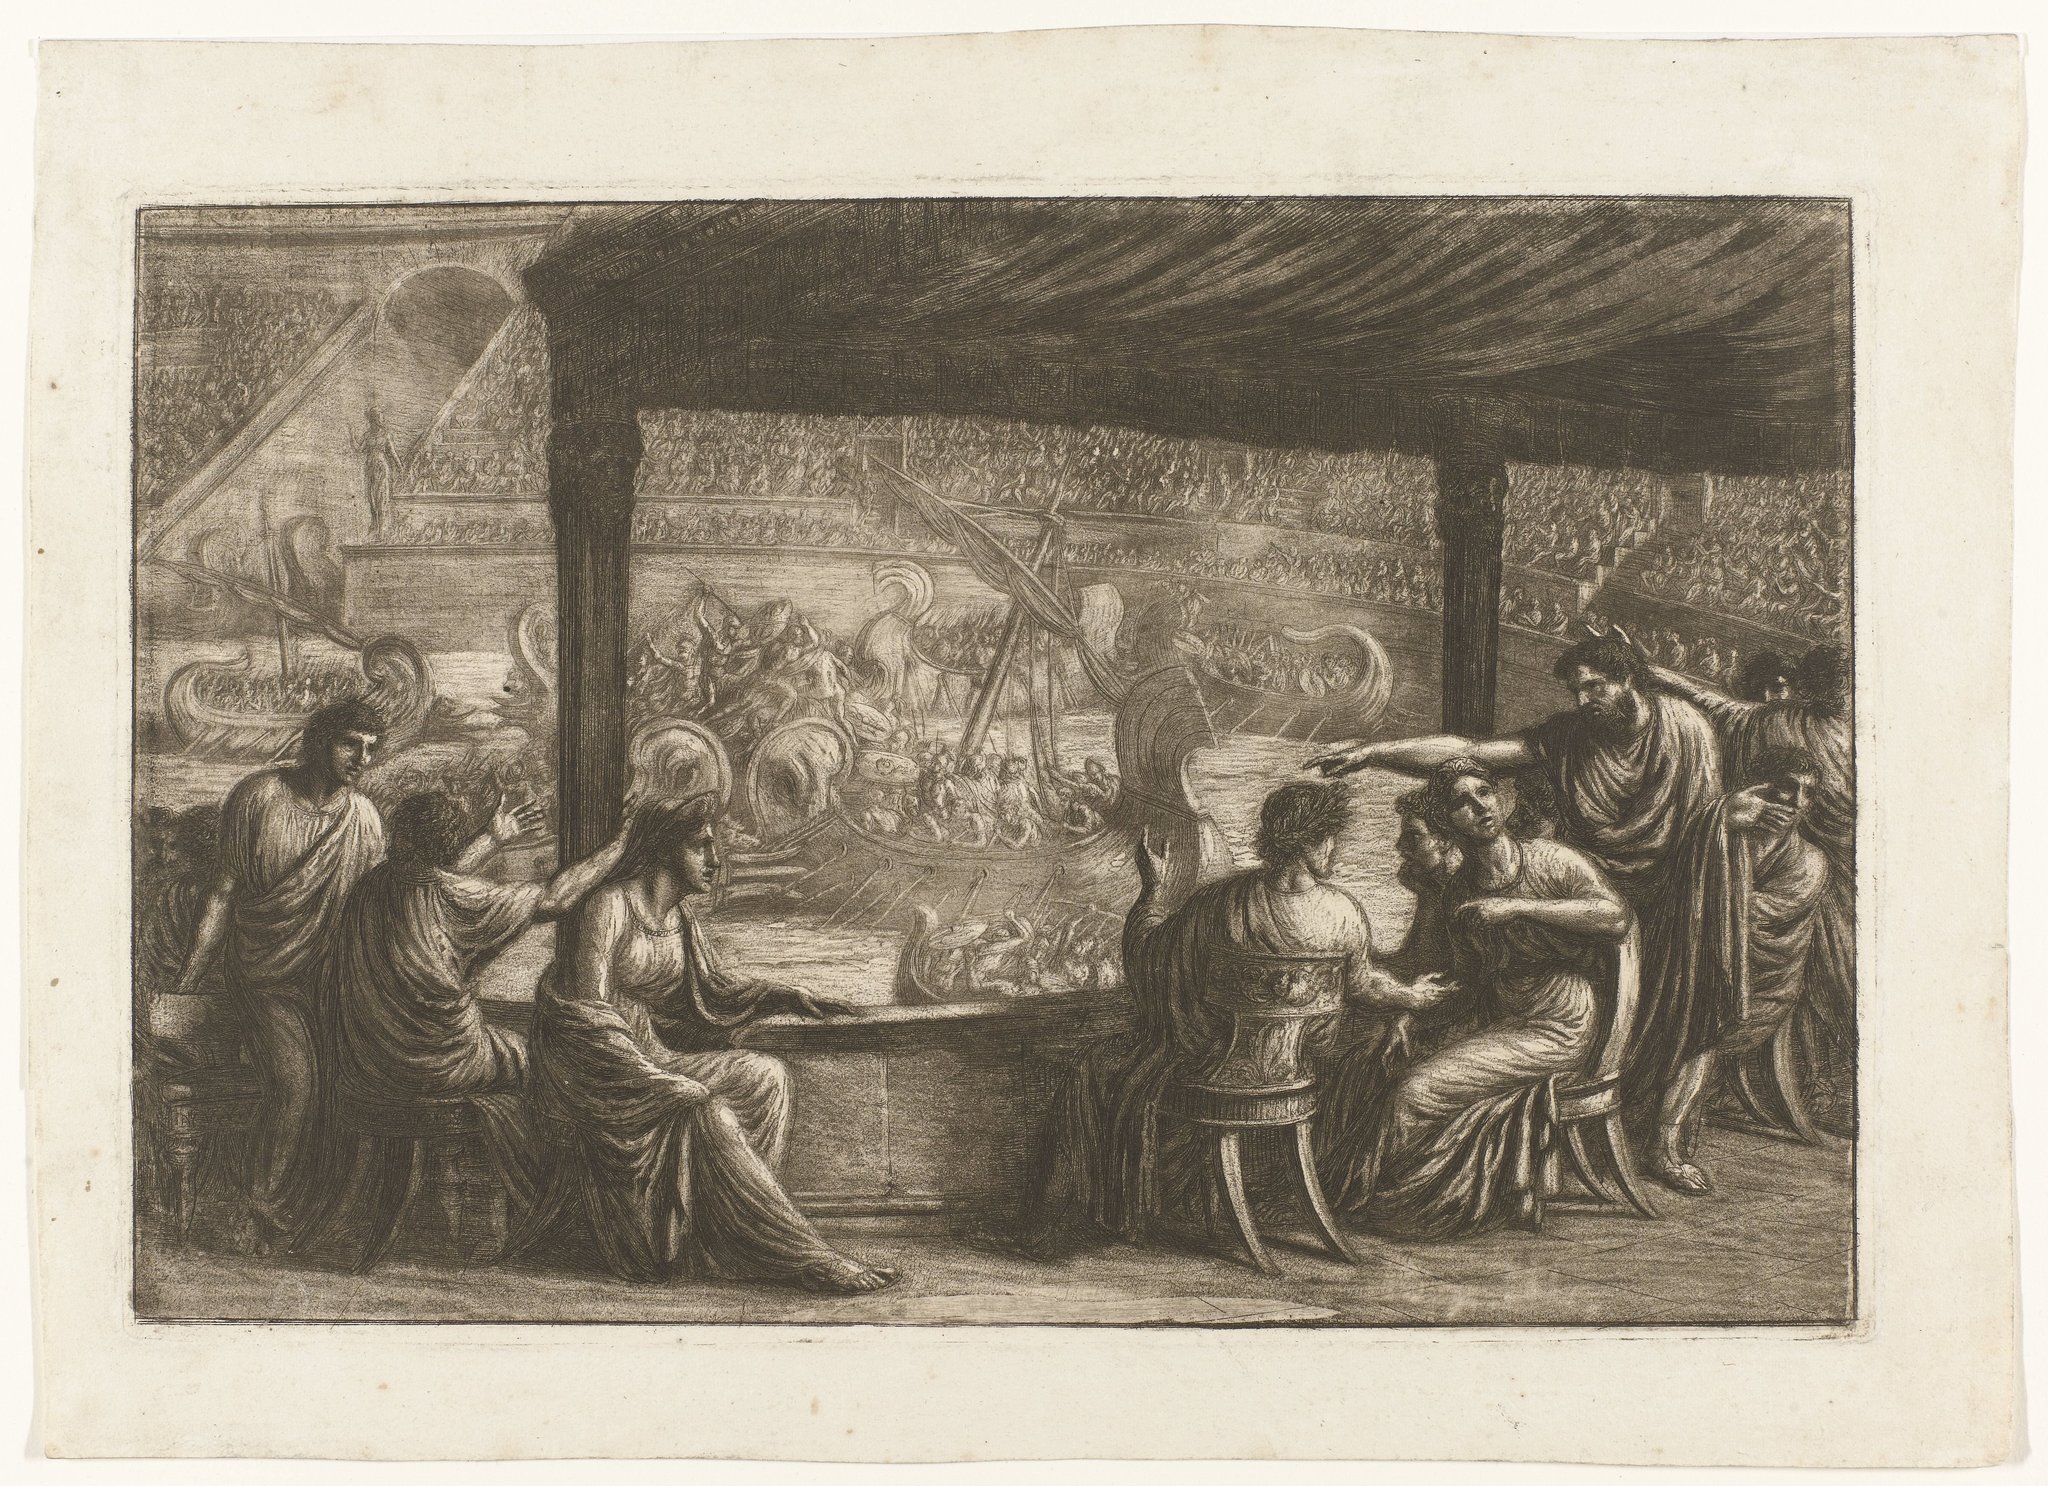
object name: print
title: Zeeslag in een Romeinse arena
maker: luigi ademollo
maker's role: draughtsman, painter, print maker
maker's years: 1764-1849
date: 1774-1849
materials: paper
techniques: aquatint, etching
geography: italy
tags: auditorium ~ theatre, etc. - aa - open-air performances, fight of gladiators, the audience ~ art performance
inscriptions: collector's mark: Lugt 2228, collector's mark: Lugt 2760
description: Vanaf een overdekt gedeelte van een tribune van een arena kijken toeschouwers naar een nagespeelde zeeslag (naumachia) door gladiatoren.